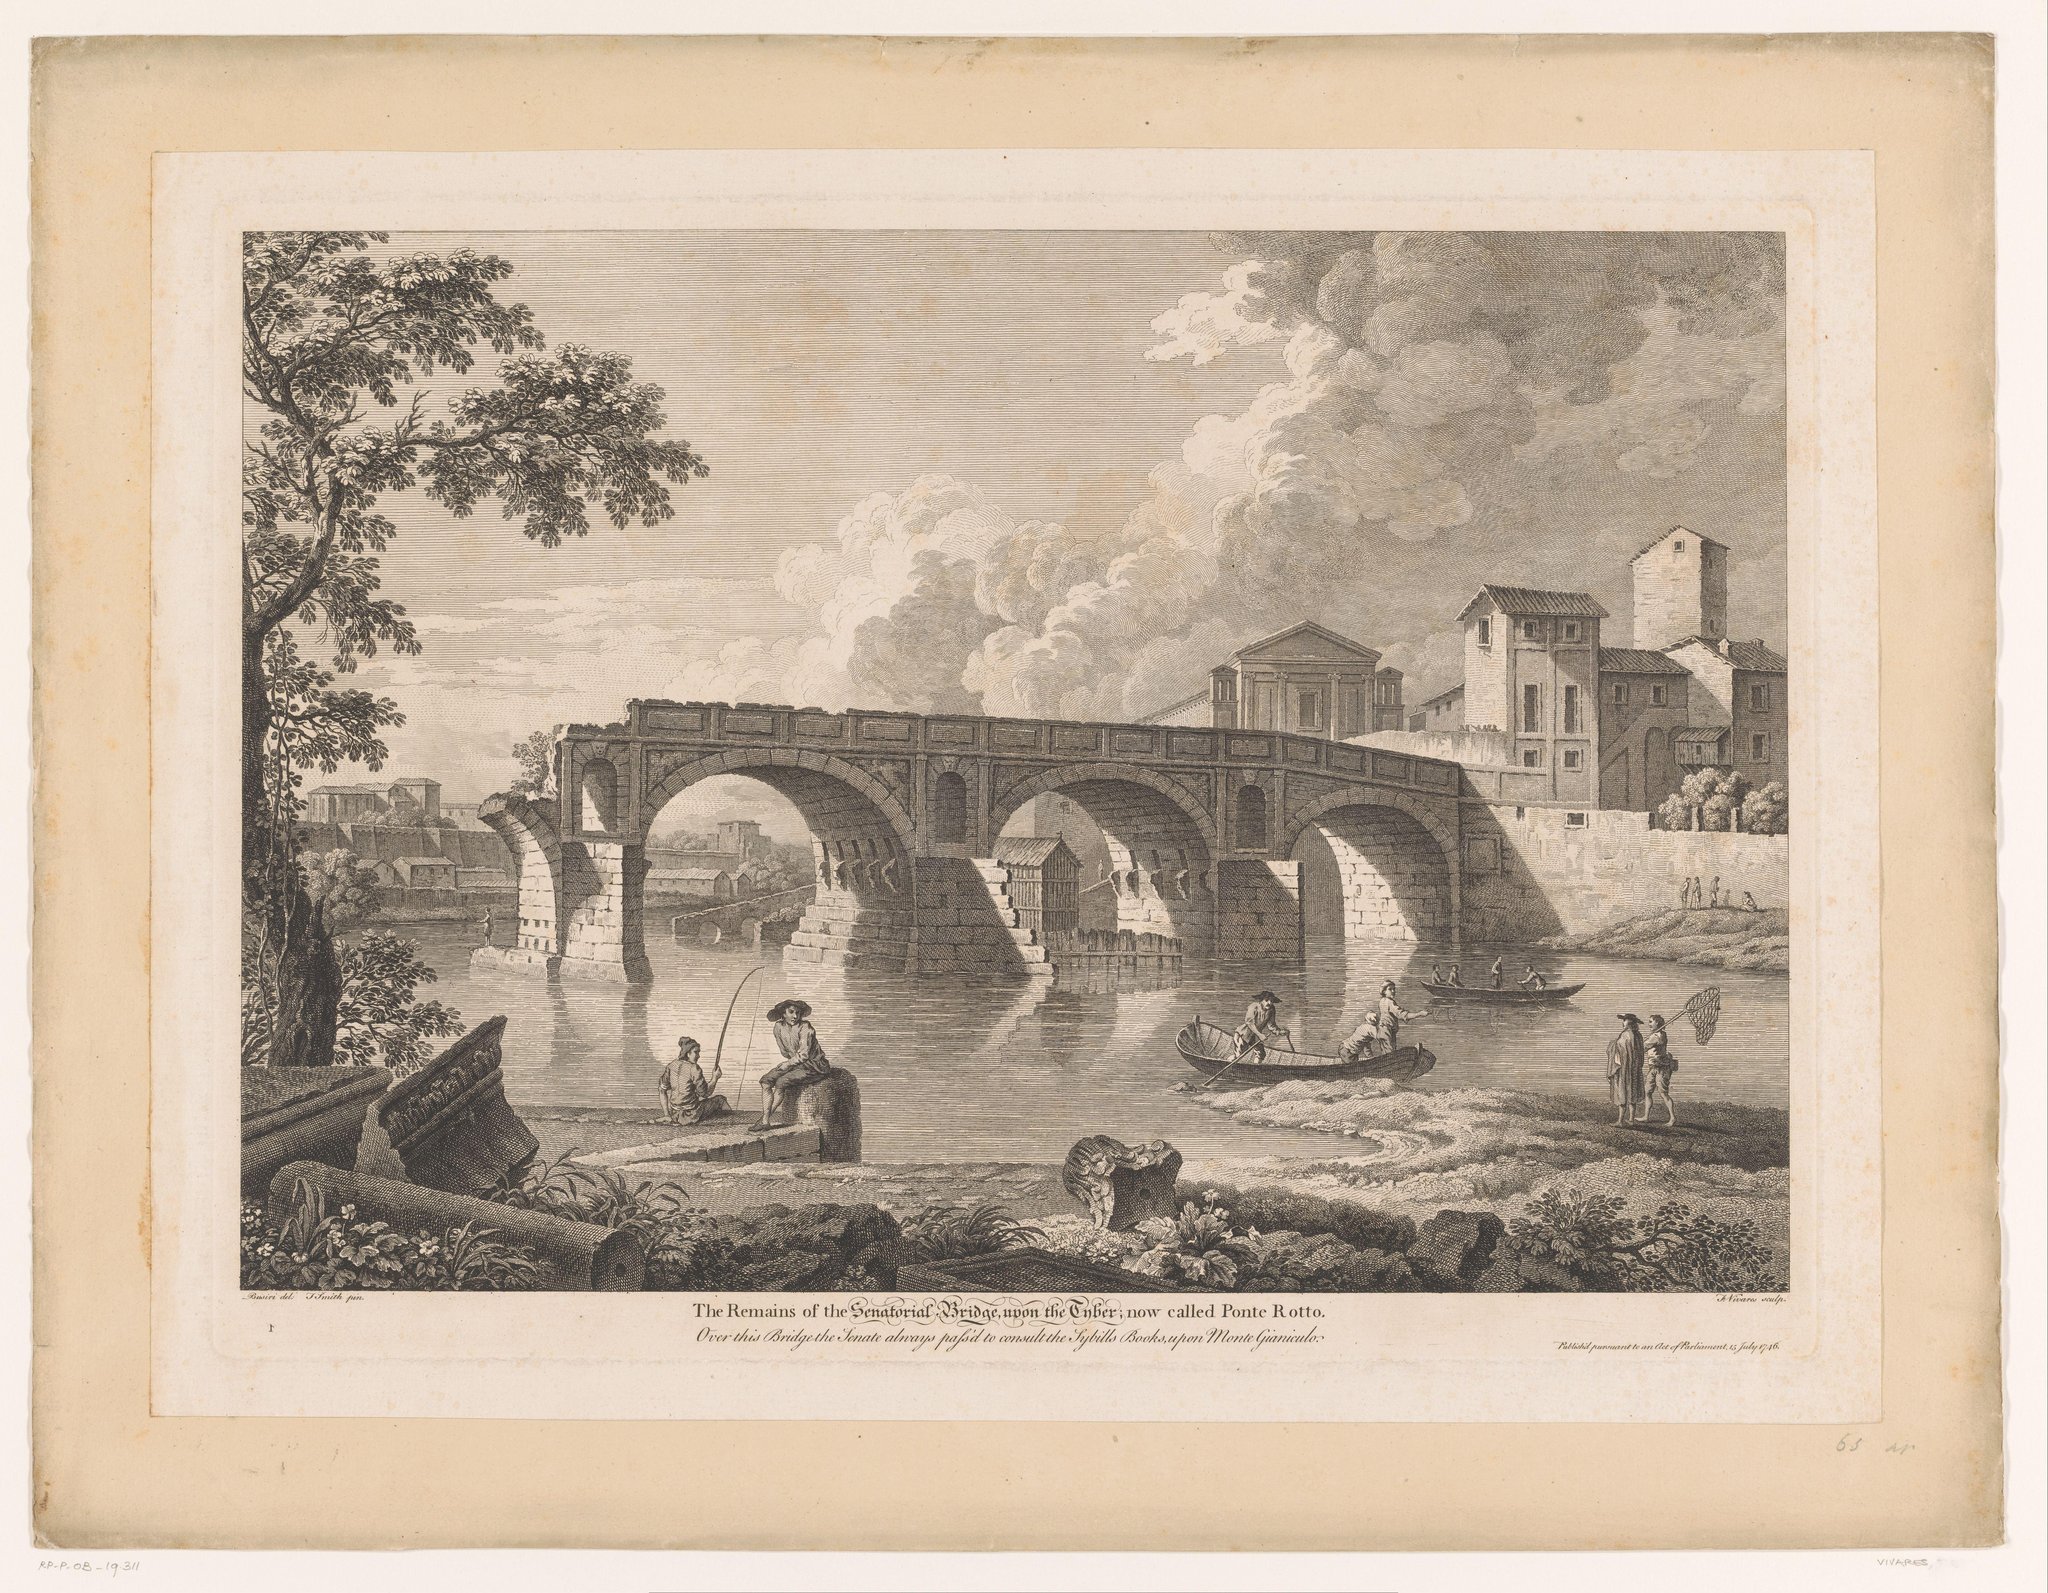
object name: print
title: The Remains of the Senatorial Bridge, upon the Tyber; now called Ponte Rotto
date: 1707-1746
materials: paper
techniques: etching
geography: london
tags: bridge in city across river, canal, etc. (+ city(-scape) with figures, staffage), landscape with ruins (+ city(-scape) with figures, staffage), angling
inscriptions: collector's mark: Lugt 2228